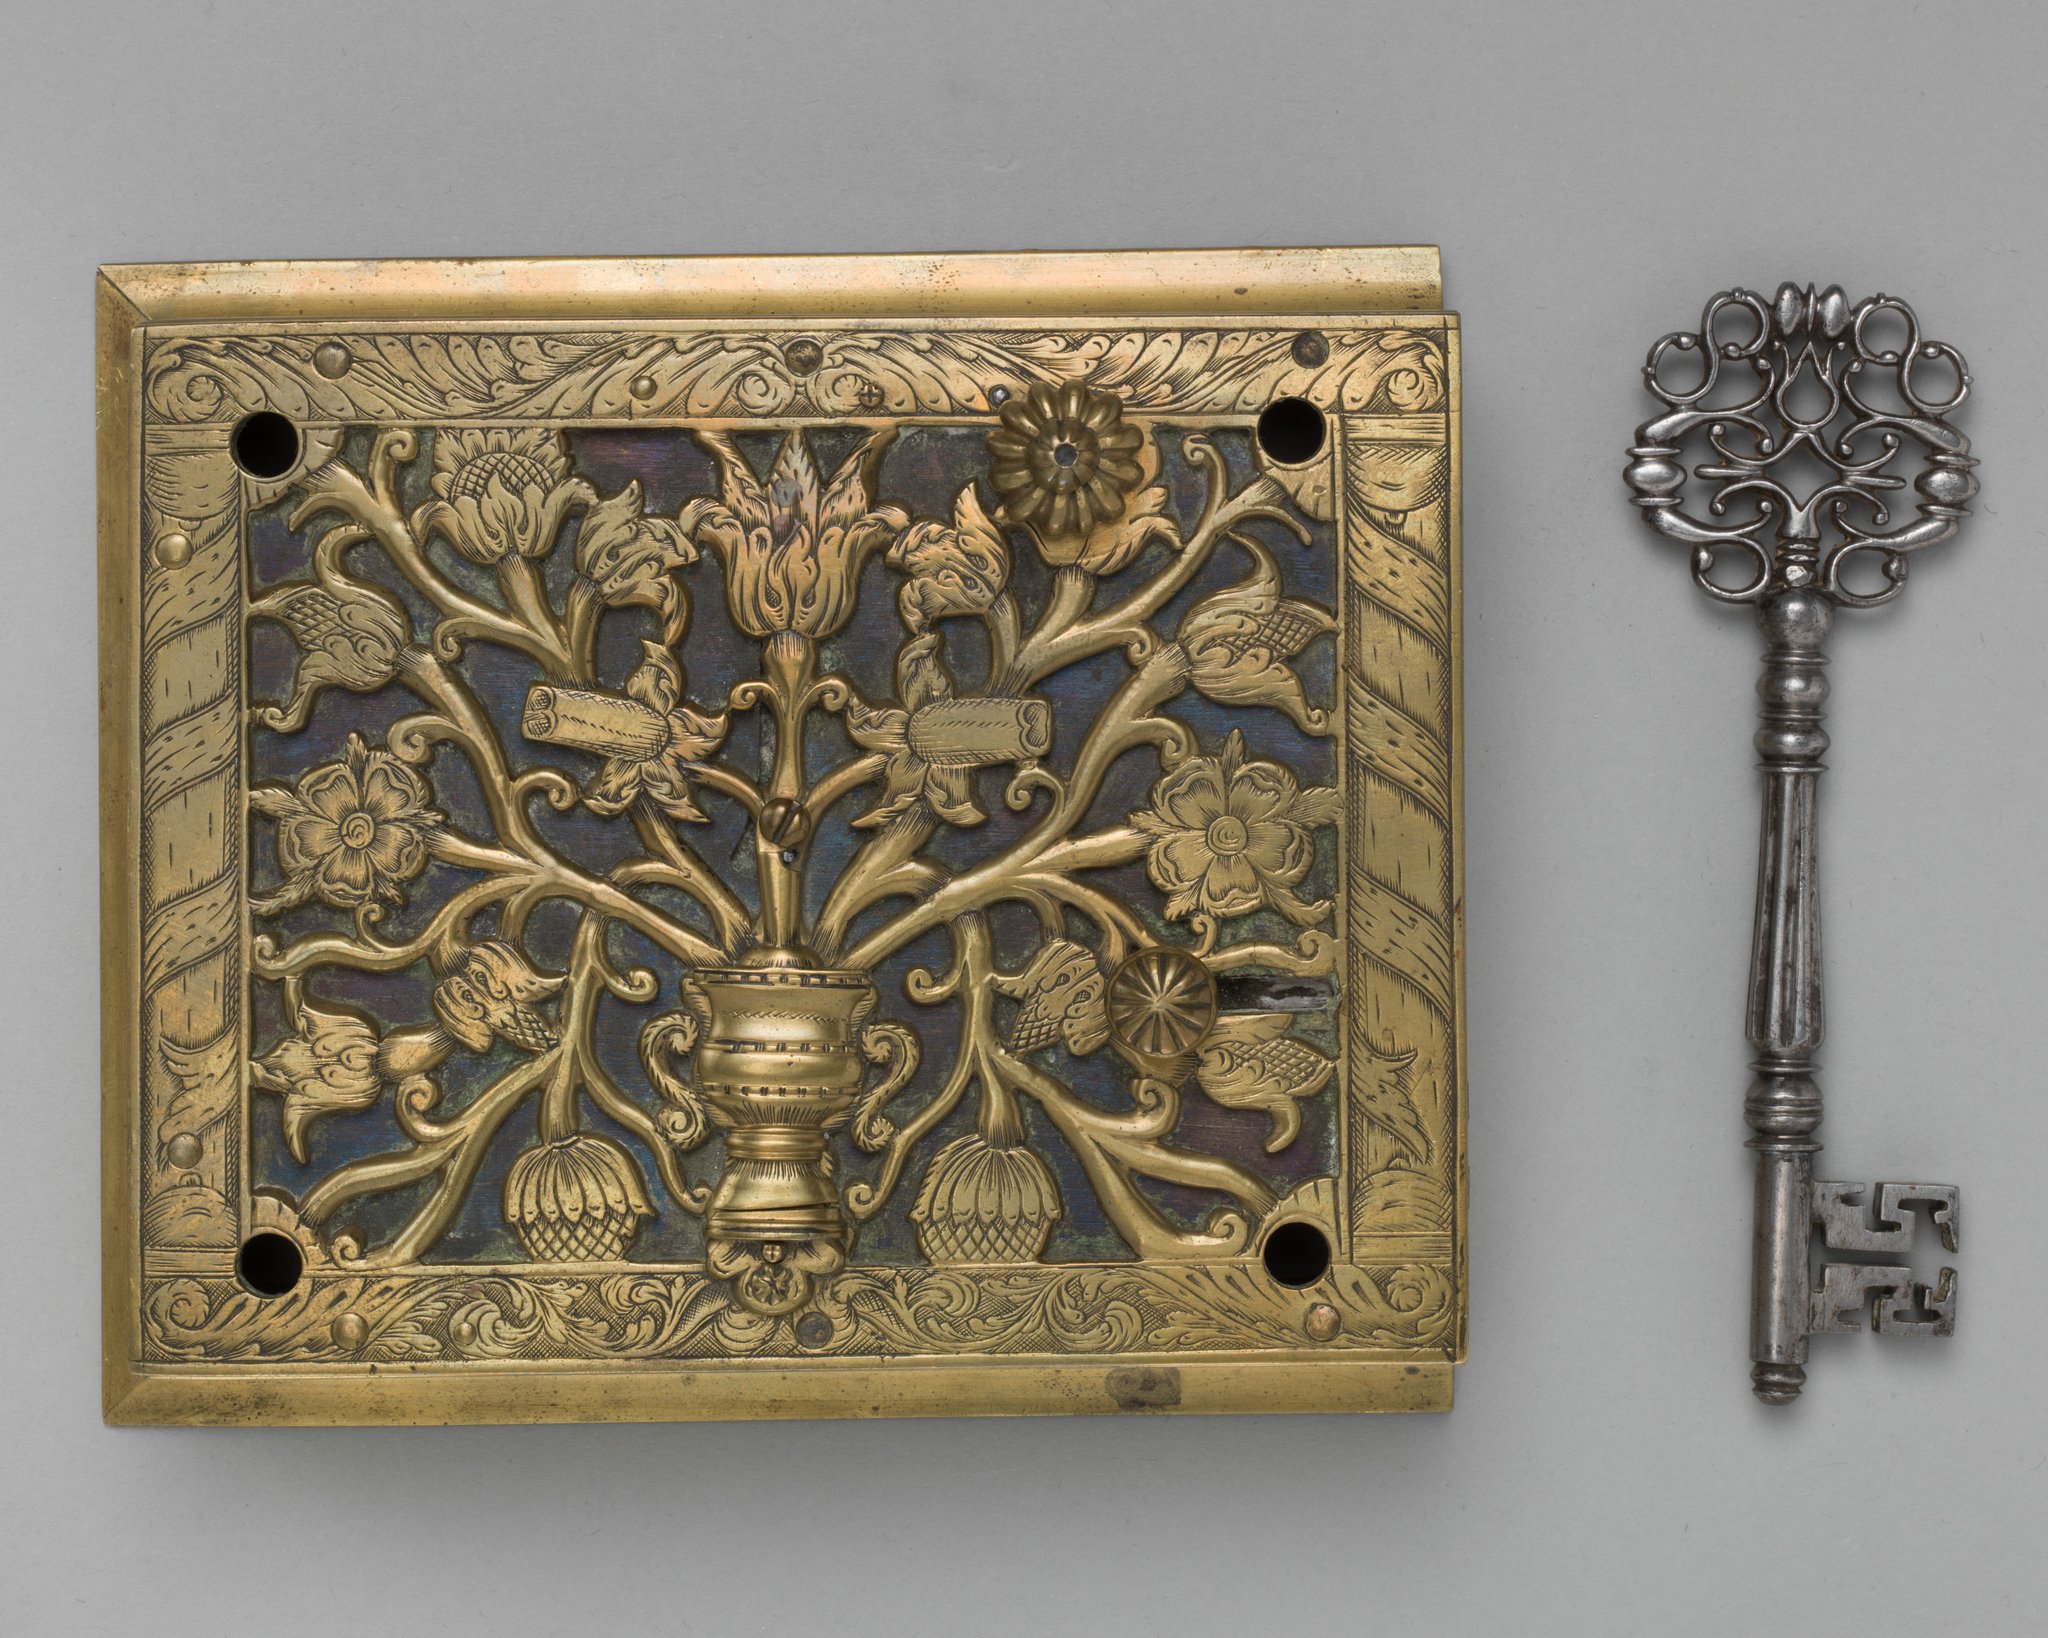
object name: lock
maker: john wilkes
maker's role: maker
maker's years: 1600-1700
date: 1601-1700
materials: brass, steel, wood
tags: flowers